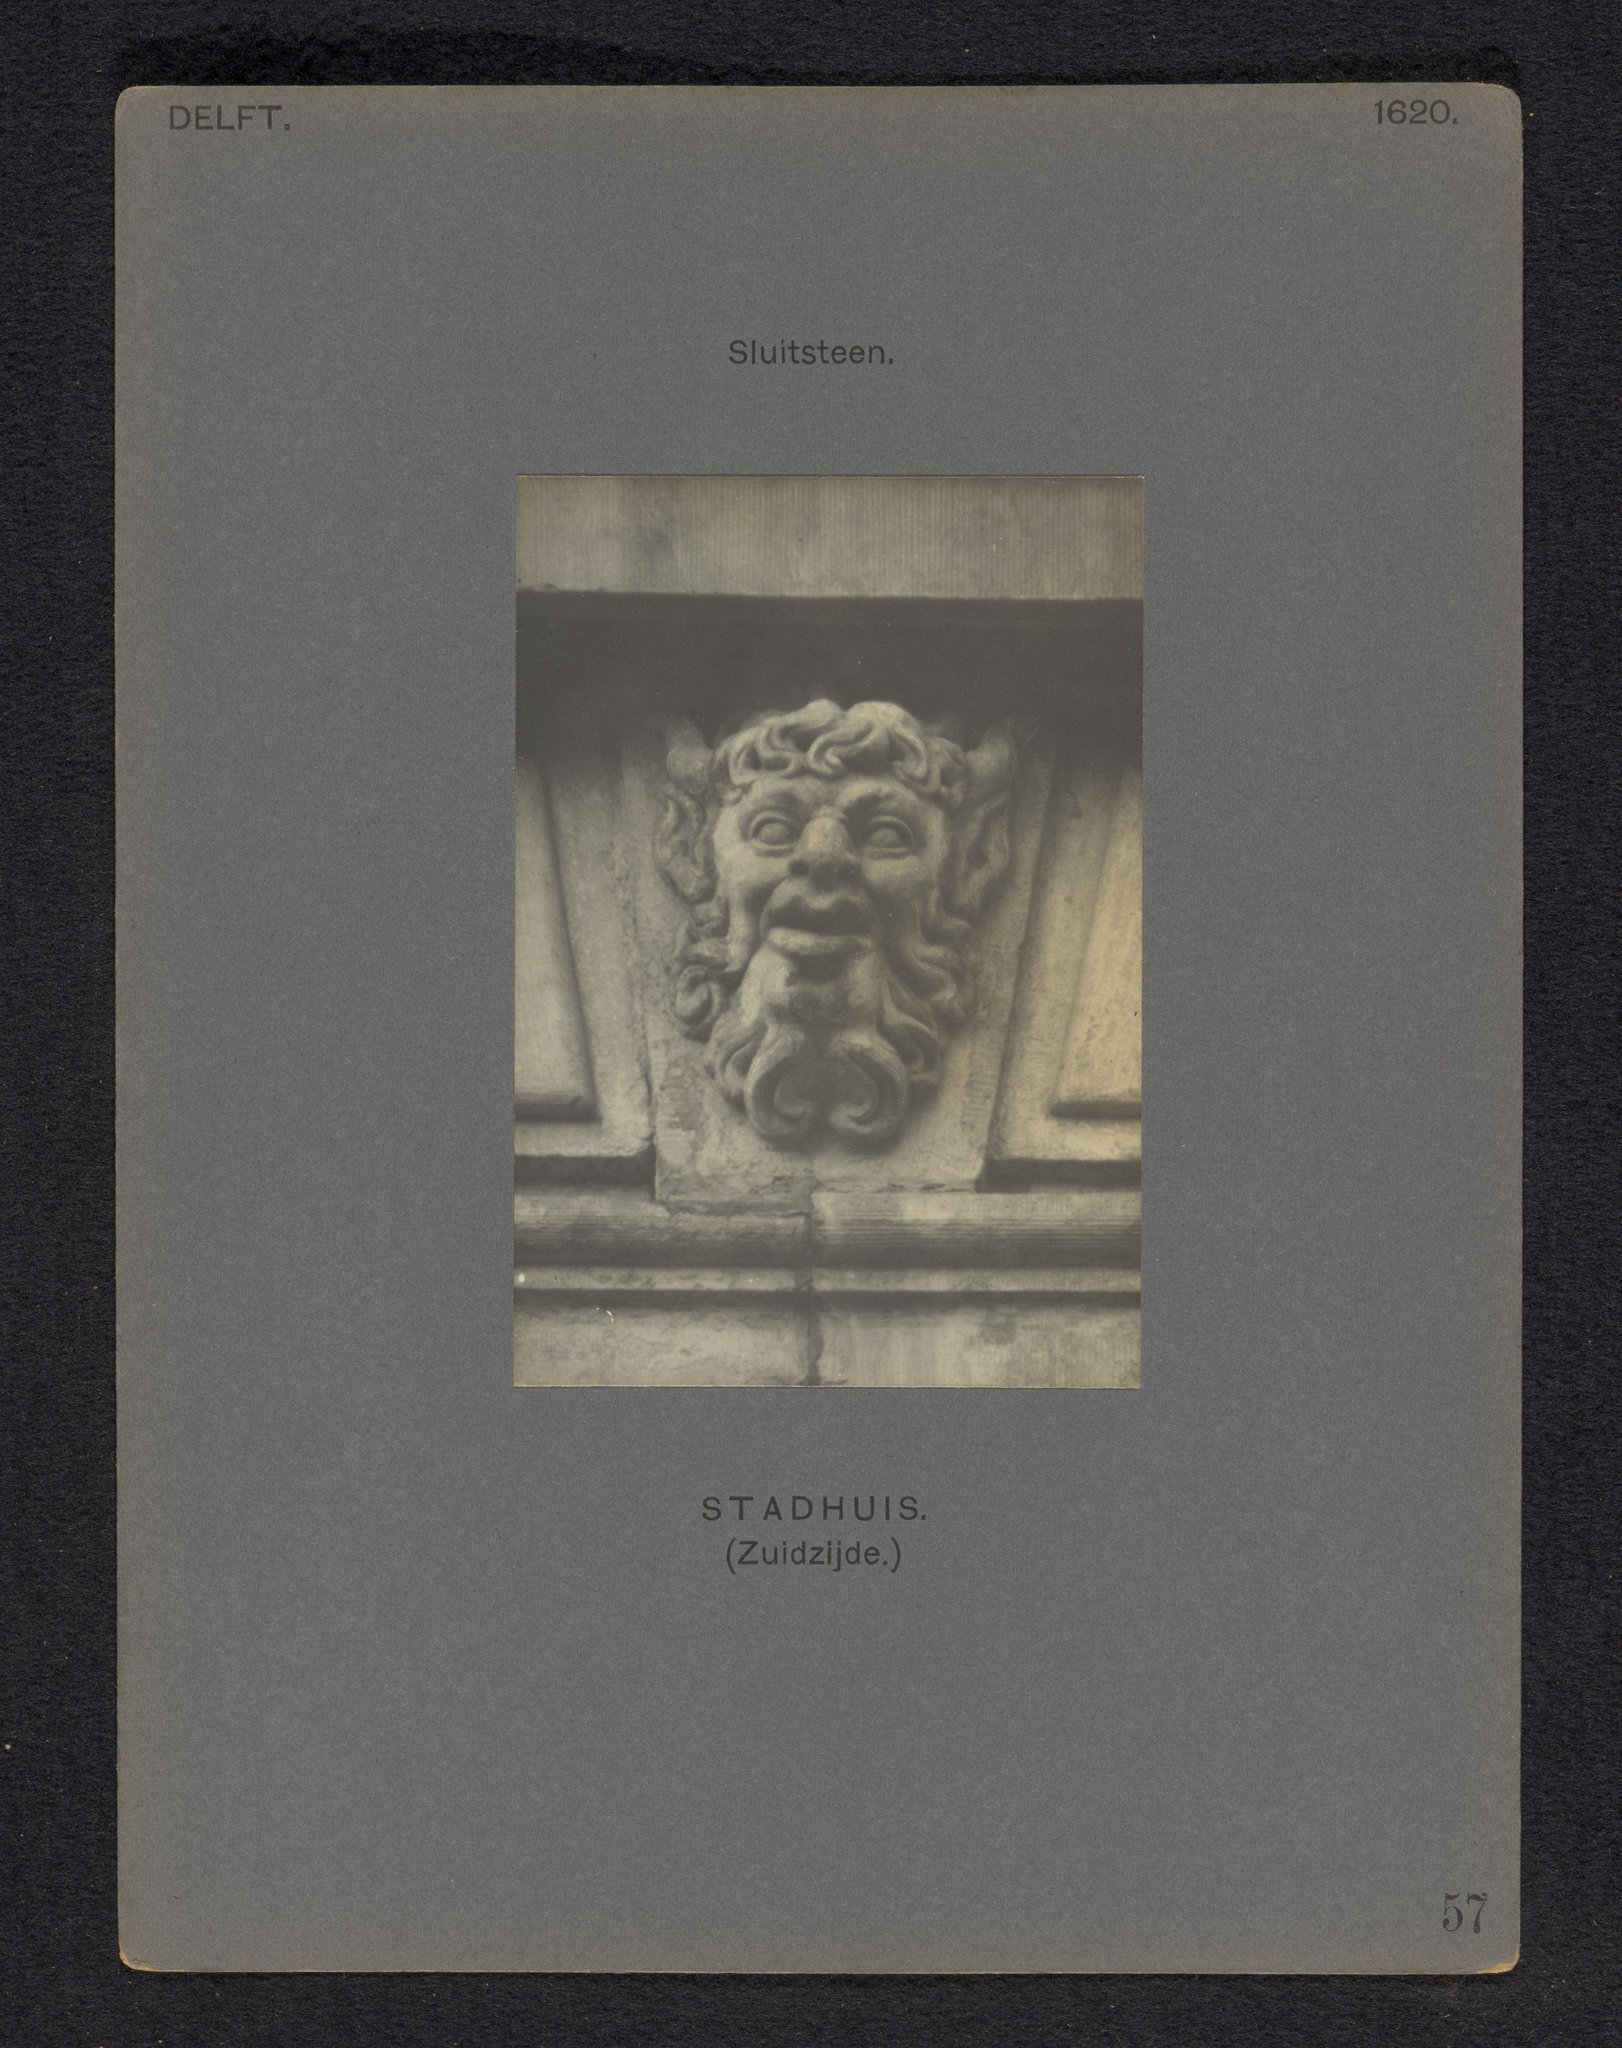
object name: photograph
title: Stadhuis (Zuidzijde.) Sluitsteen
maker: Anonymous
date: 1900-1904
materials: cardboard, photographic support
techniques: gelatin silver print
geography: delft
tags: satyrs, fauns, sileni, keystone ~ architecture, townhall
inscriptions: inscription: ‘Het recht van reproductie dezer photo's wordt door den Uitgever voorbehouden.’, inscription: ‘Delft. 1620’, number: ‘57’